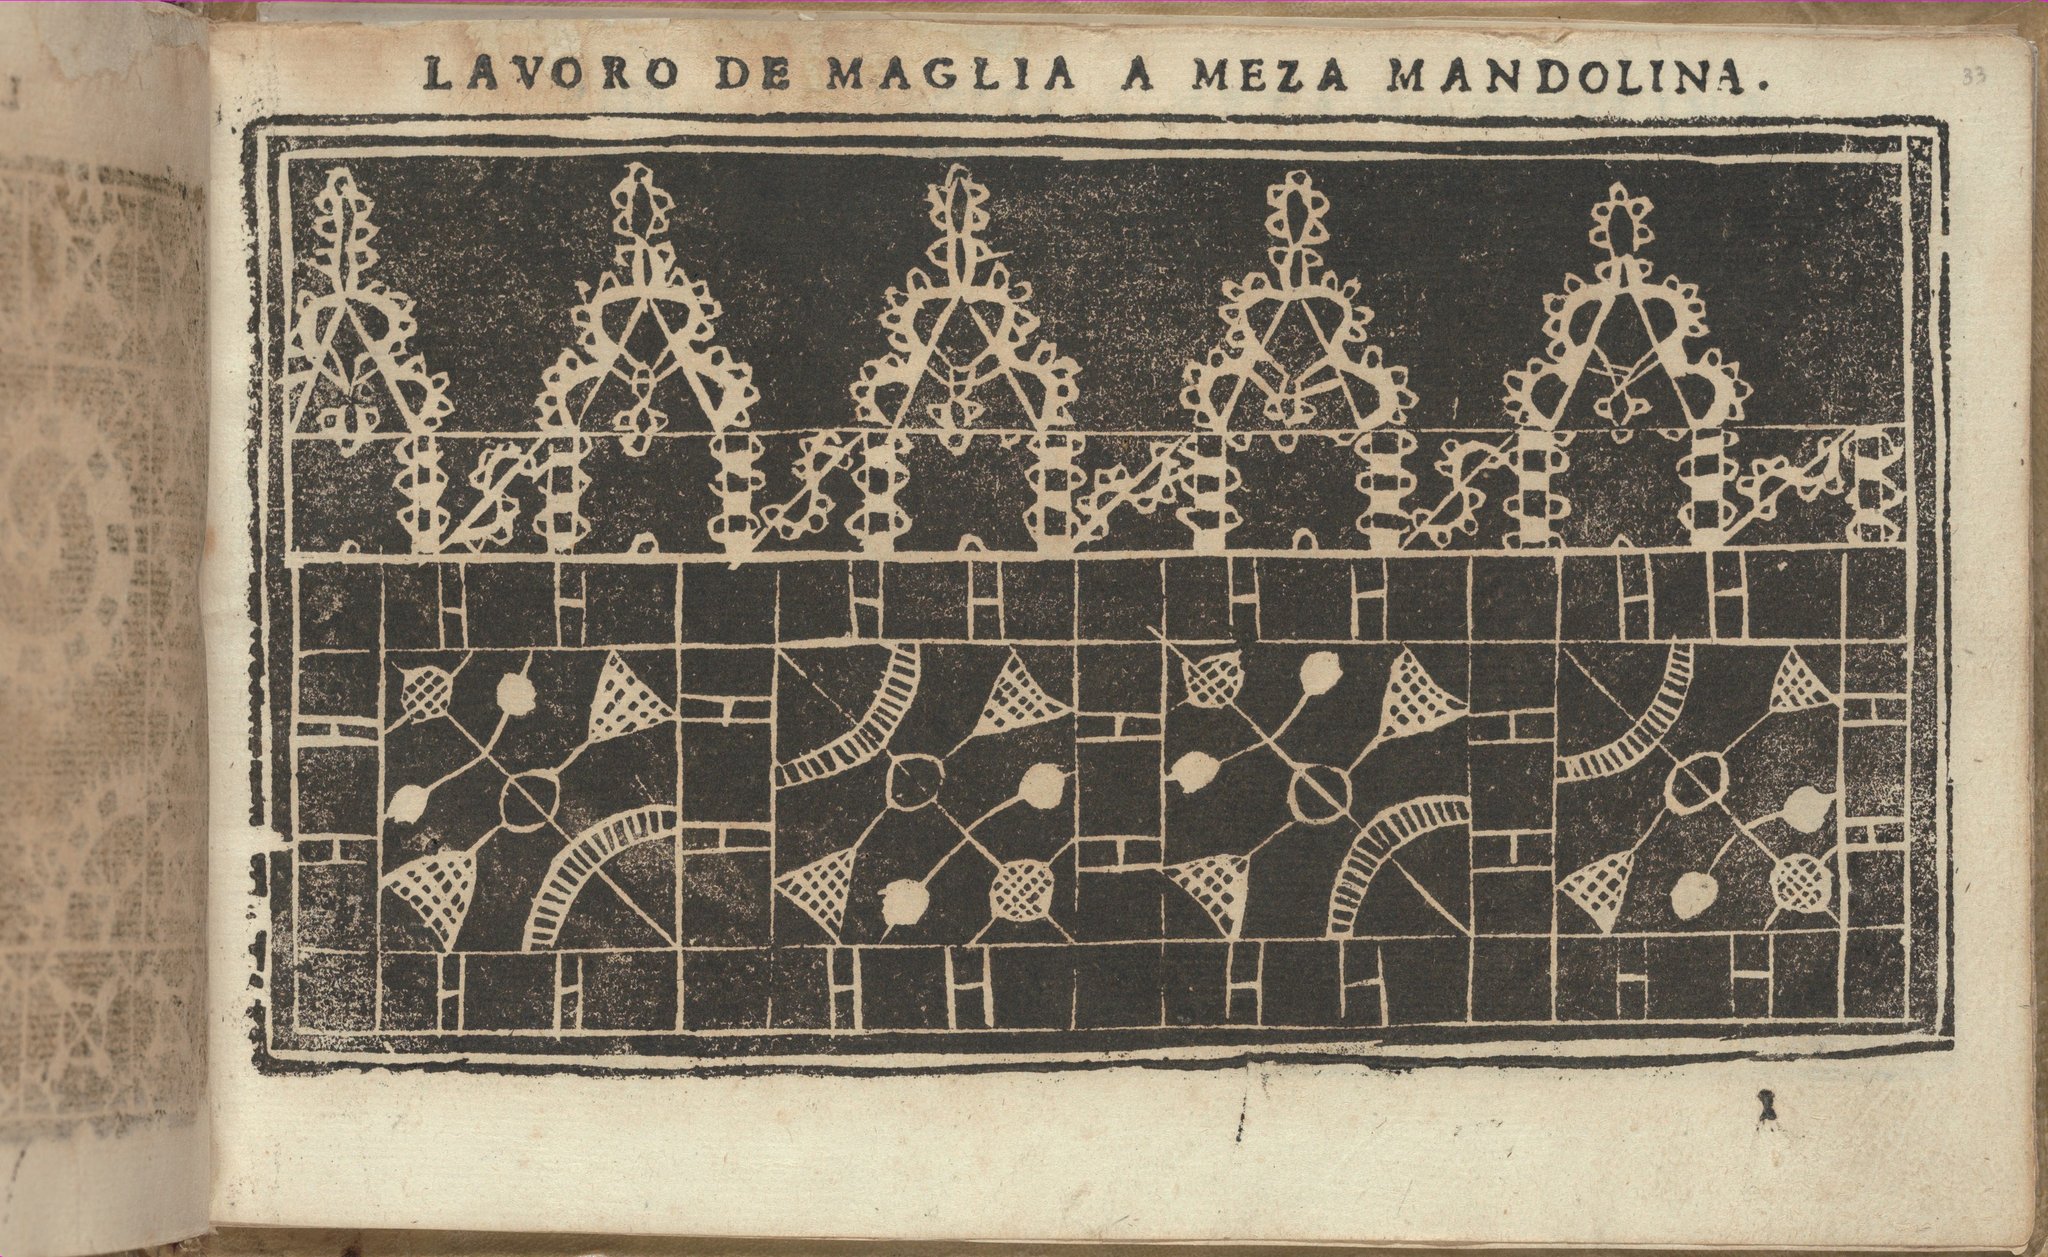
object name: book print ornament architecture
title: Studio delle virtuose Dame, page 33 (recto)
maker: isabella catanea parasole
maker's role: designer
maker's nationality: italian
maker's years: 1565-1625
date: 1597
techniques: woodcut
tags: ornament